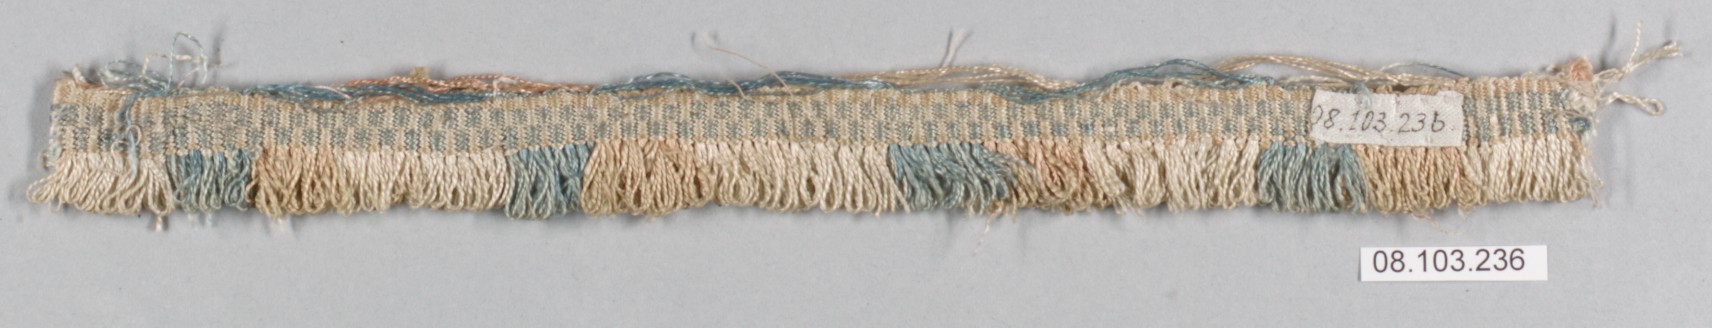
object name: gimp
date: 1701-1800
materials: silk